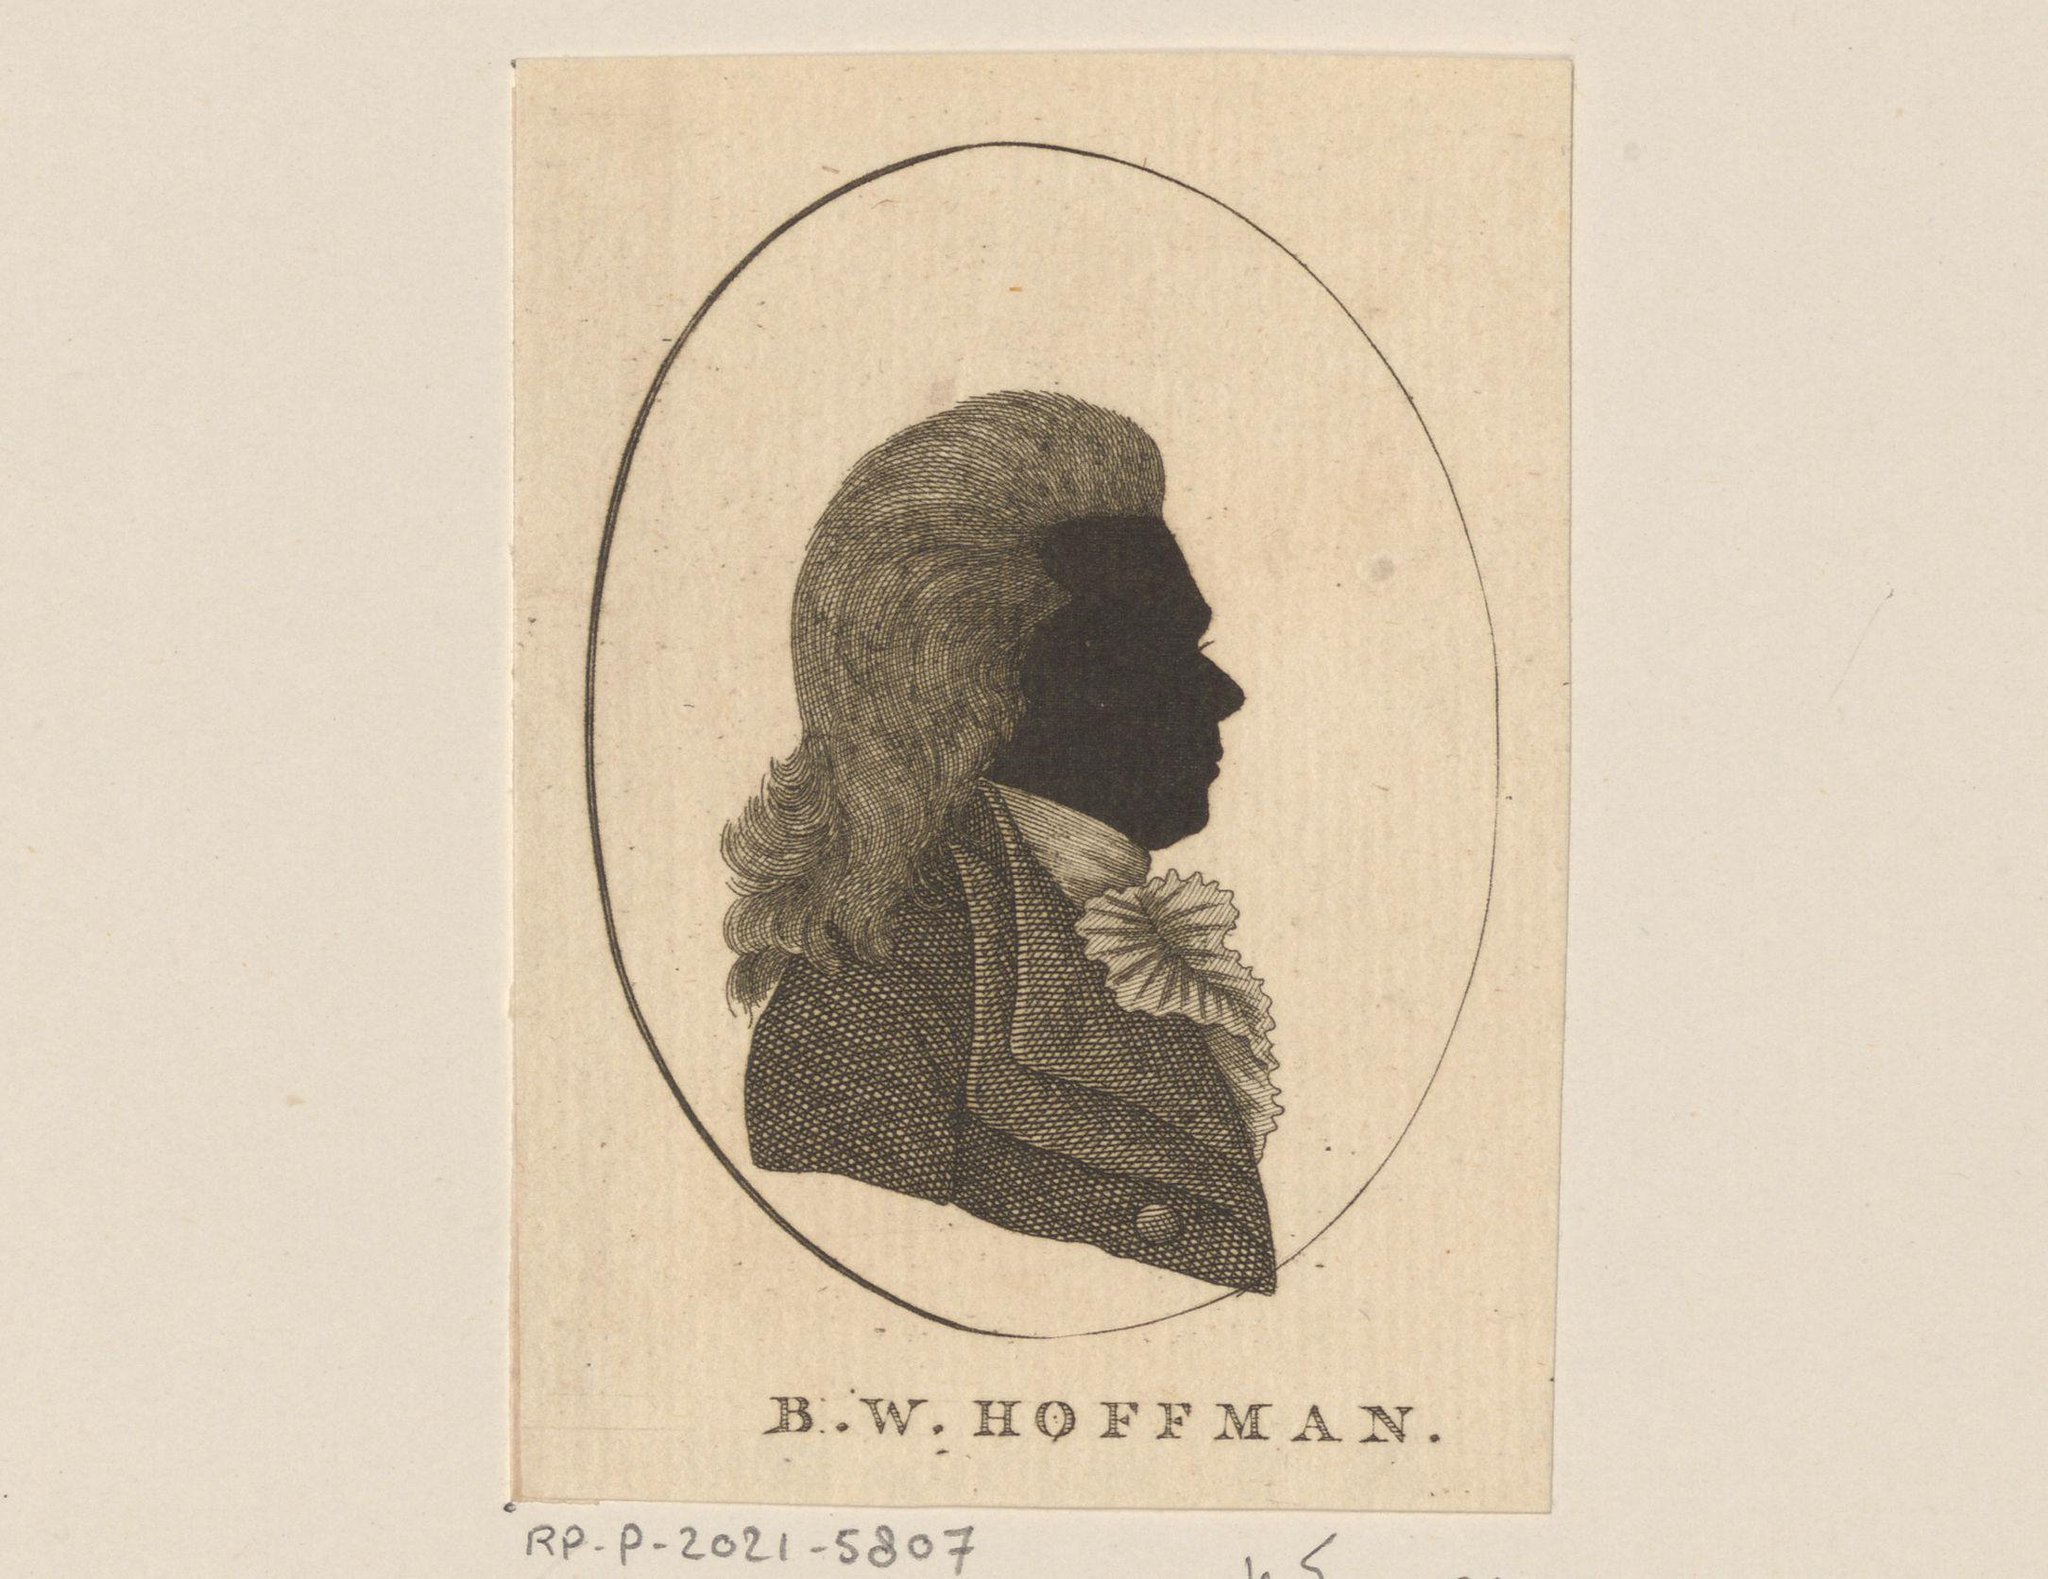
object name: print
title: Silhouetportret van Bernardus Wilhelmus Hoffman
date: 1799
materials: paper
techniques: etching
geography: amsterdam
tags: historical persons, politician, e.g. party leader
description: Prent uit: Rogge, Cornelis. Geschiedenis der staatsregeling, voor het Bataafsche volk. Amsterdam: Johannes Allart, 1799.